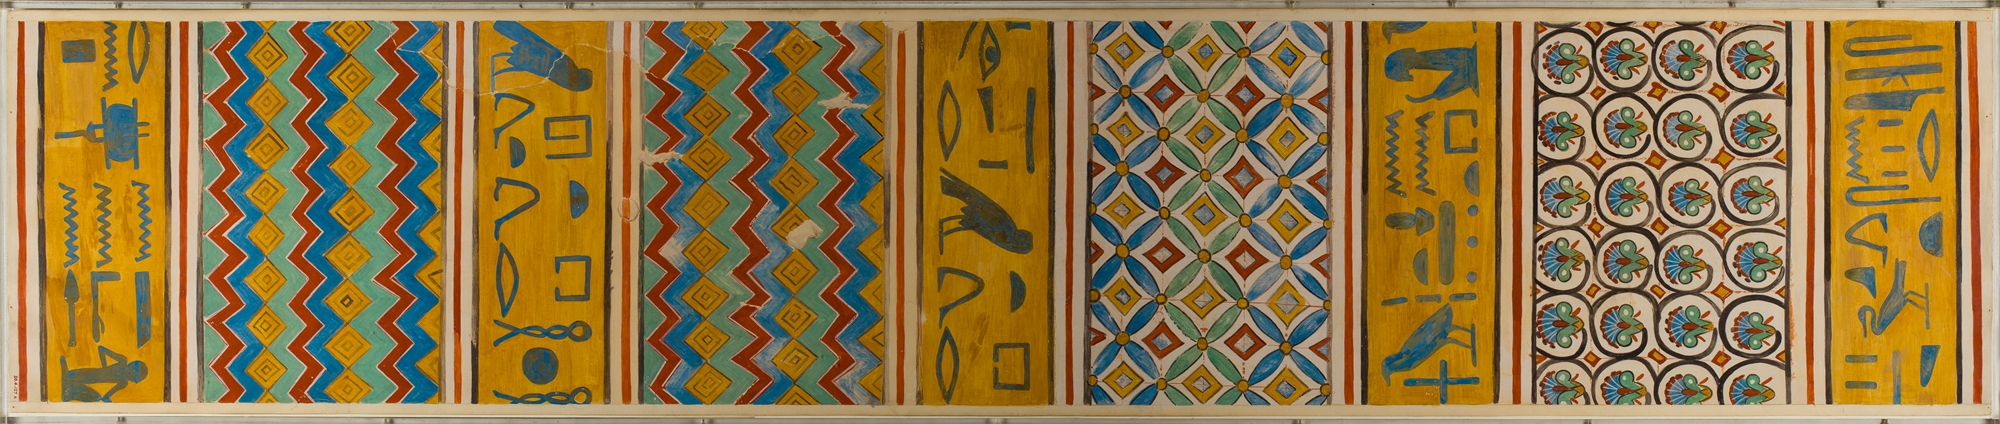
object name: facsimile, tjay tt 349, ceiling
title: Ceiling Decoration, Tomb of Tjay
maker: charles k. wilkinson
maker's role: artist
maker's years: 1897-1986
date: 1550-1458 BCE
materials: paper, paint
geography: egypt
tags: hieroglyphs